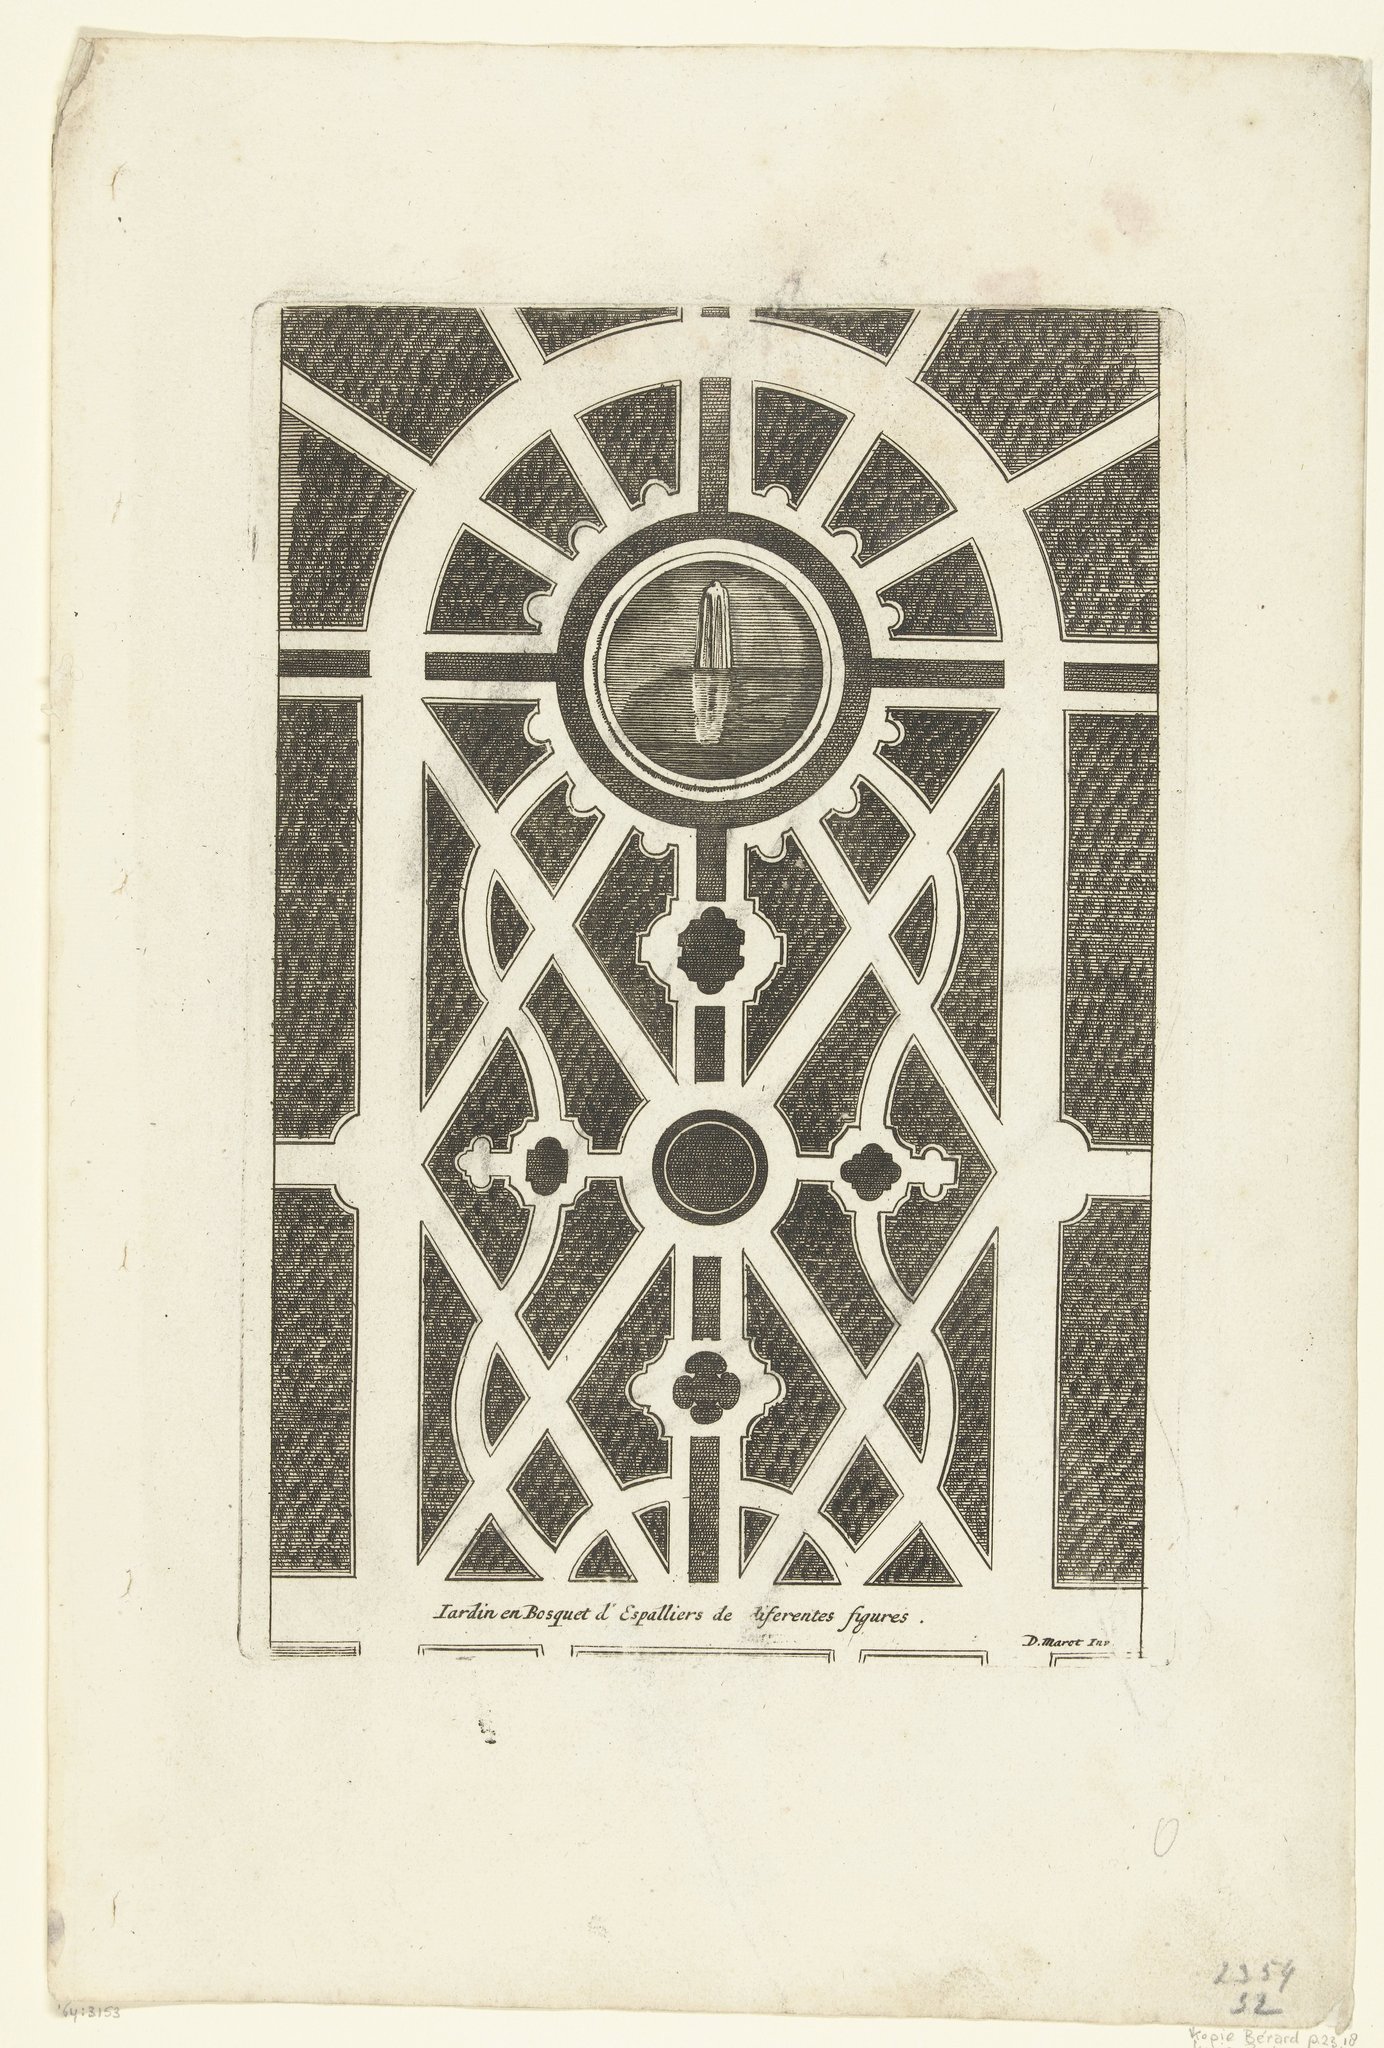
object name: ornament print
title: Iardin en Bosquet d'Espalliers de diferentes figures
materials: paper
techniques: etching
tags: lay-out of garden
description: De paden liggen tussen struikgewas.Tegenzijdige kopie naar prent uit serie Nouveux Livre de Parterres uitgegeven door Daniel Marot. Blad uit serie tuinontwerpen met parterres, fonteinen en paviljoenen met latwerk.